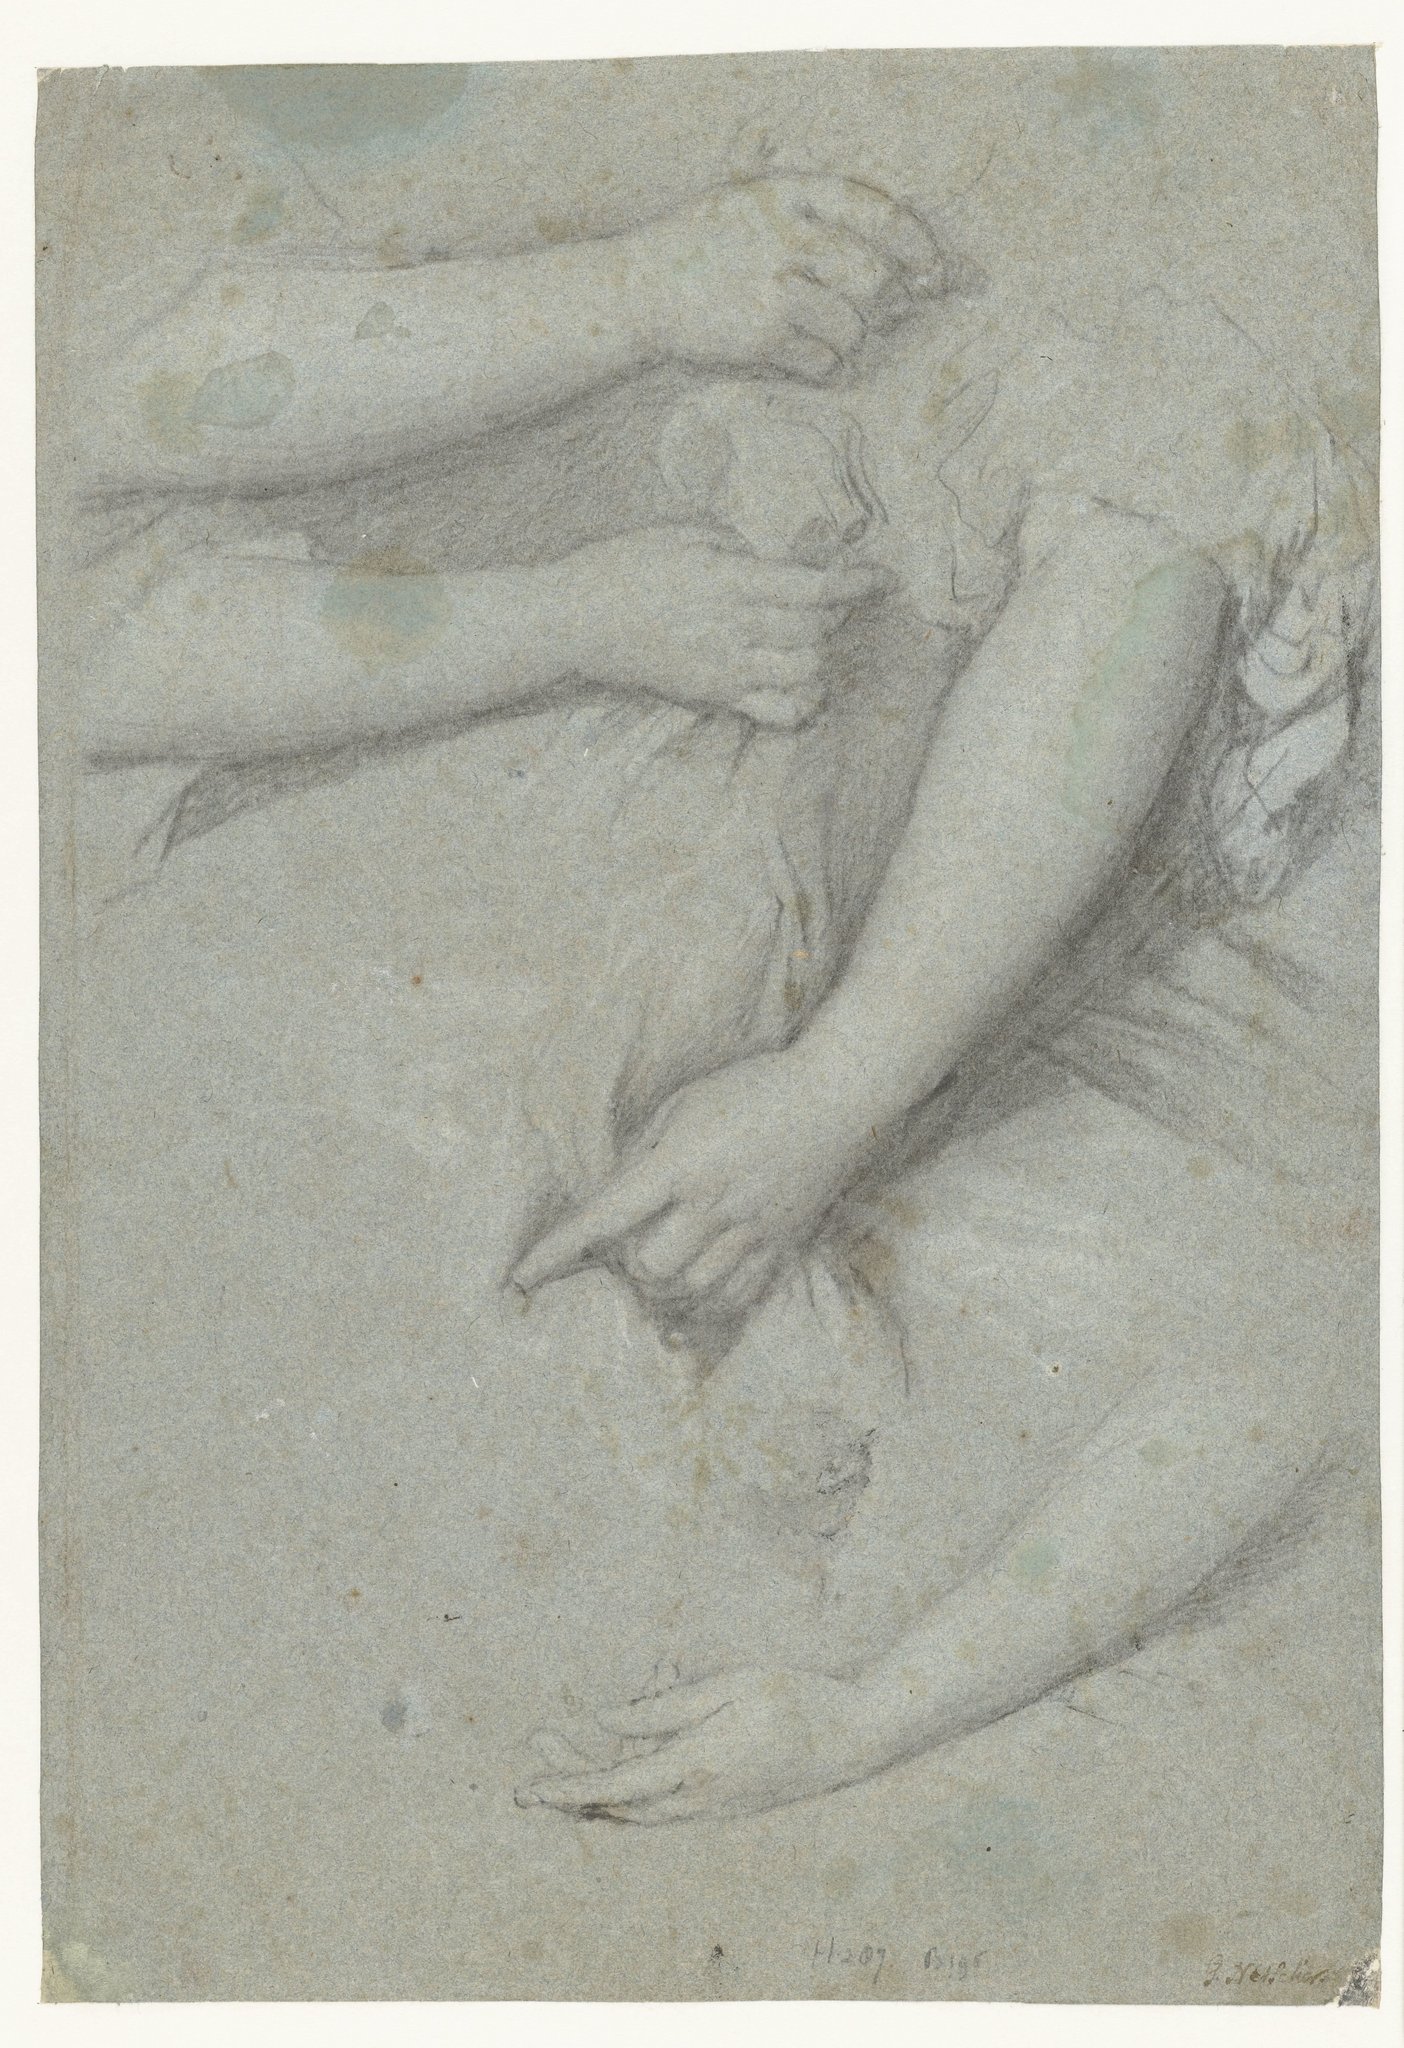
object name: drawing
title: Vier studies van de arm van een vrouw, met draperie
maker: caspar netscher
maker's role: draughtsman, painter, print maker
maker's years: 1639-1684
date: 1649-1684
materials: chalk, paper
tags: arms